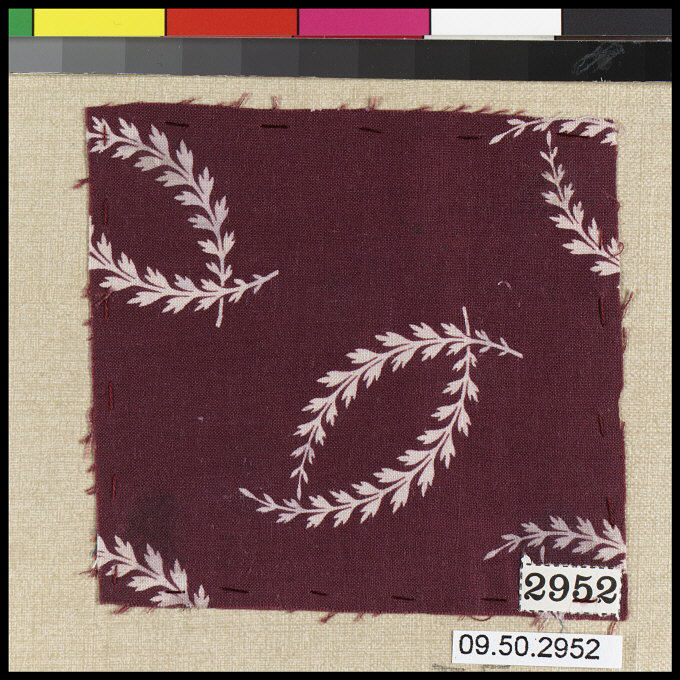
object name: piece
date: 1801-1900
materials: cotton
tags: leaves